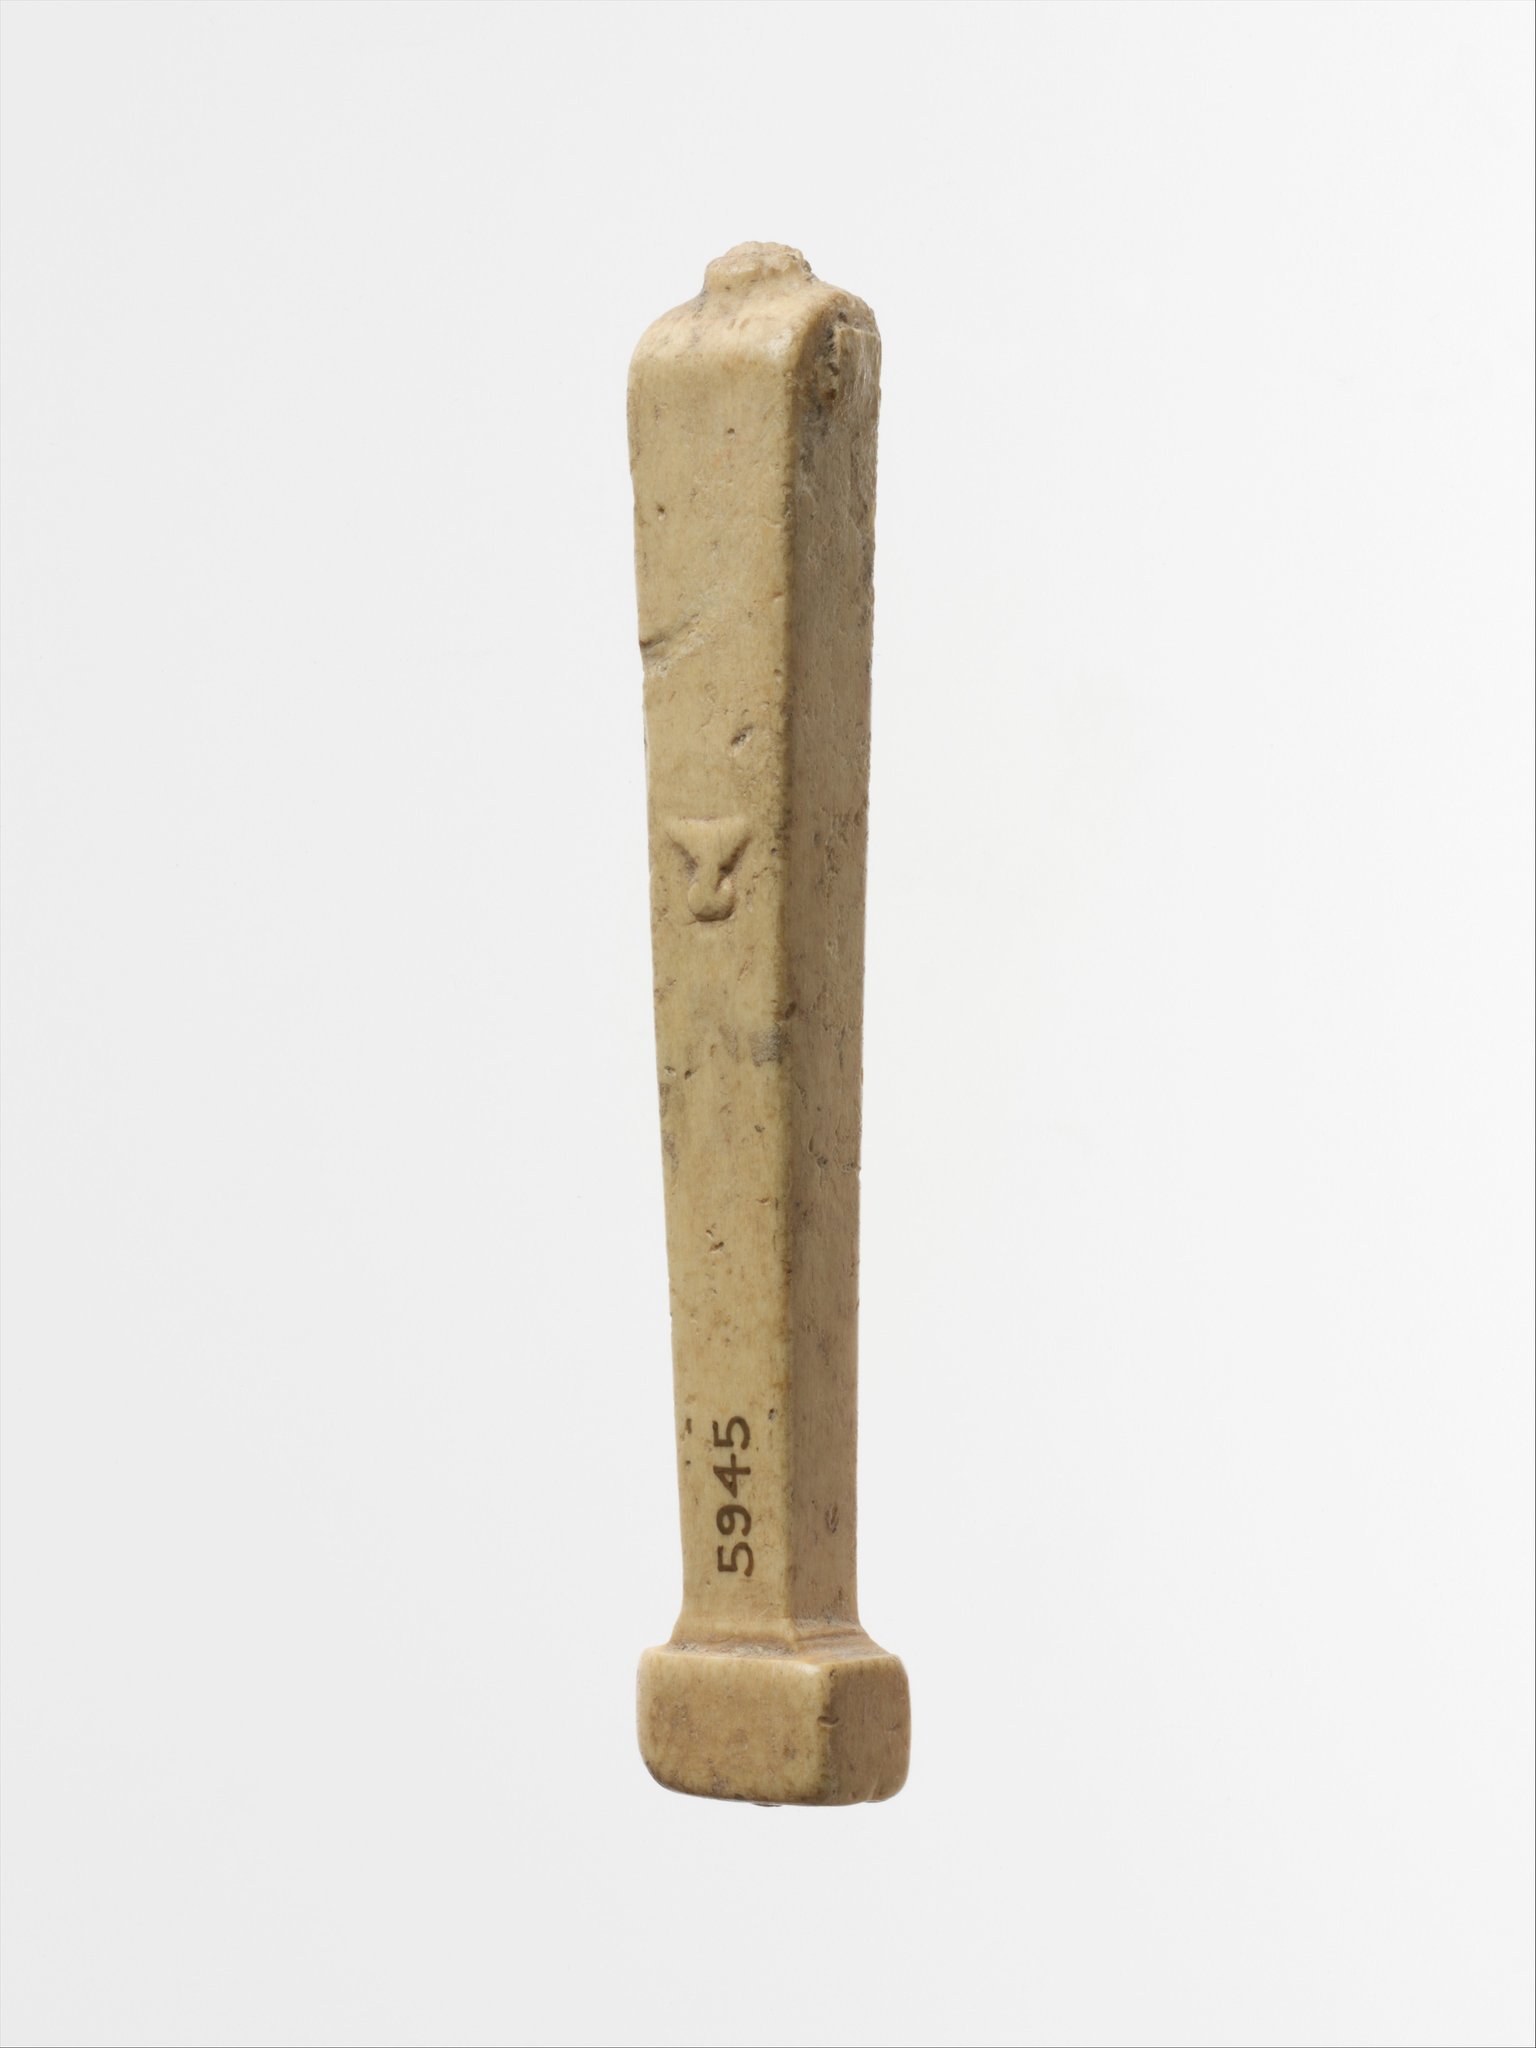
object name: herm pillar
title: Bone object in the shape of a herm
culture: roman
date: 1-100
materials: bone